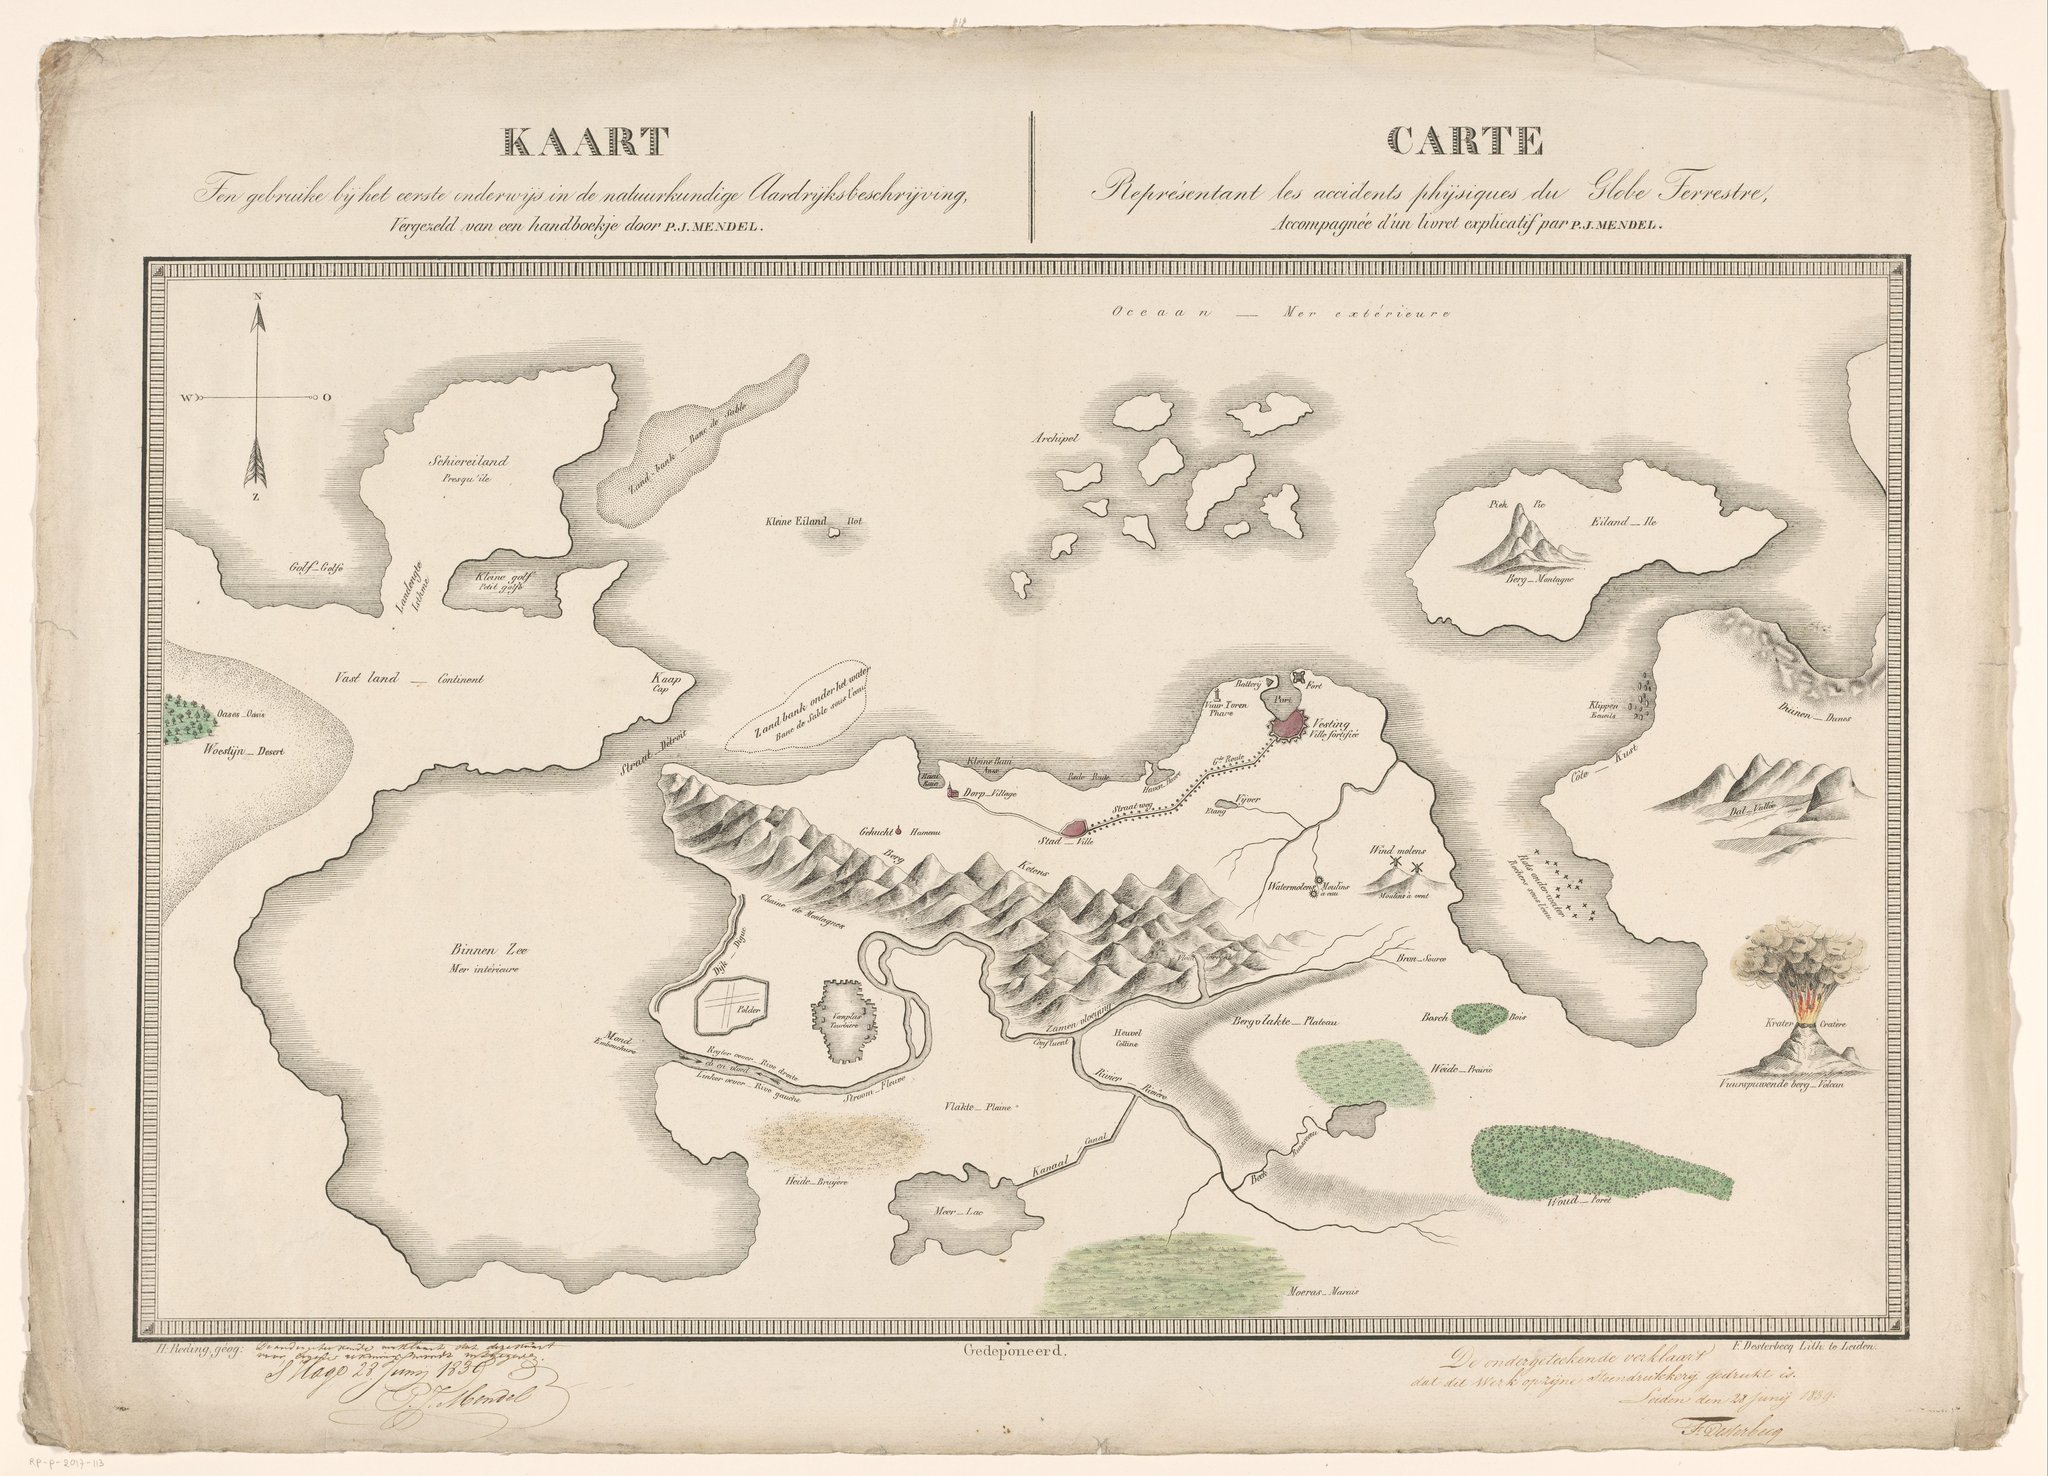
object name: print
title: Topografische kaart van een niet bestaand gebied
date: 1839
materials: paper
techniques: lithograph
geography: the hague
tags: river, maps, atlases, lake, volcano, mountains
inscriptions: : ‘De ondergeteekende verklaart dat deze plaat / voor (...) uitgegeven / 's Hage 28 junij 1839 / P.J. Mendel’, : ‘De ondergeteekende verklaart / dat dit werk op zijne steendrukkerij gedrukt is / Leiden den 28 junij 1839 / F. Desterbecq’, : ‘Gedeponeerd.’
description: Op de kaart, gemaakt voor het onderwijs, zijn alle topografische kenmerken en gebieden afgebeeld zoals meren, rivieren, gebergten, steden en een vuurtoren.